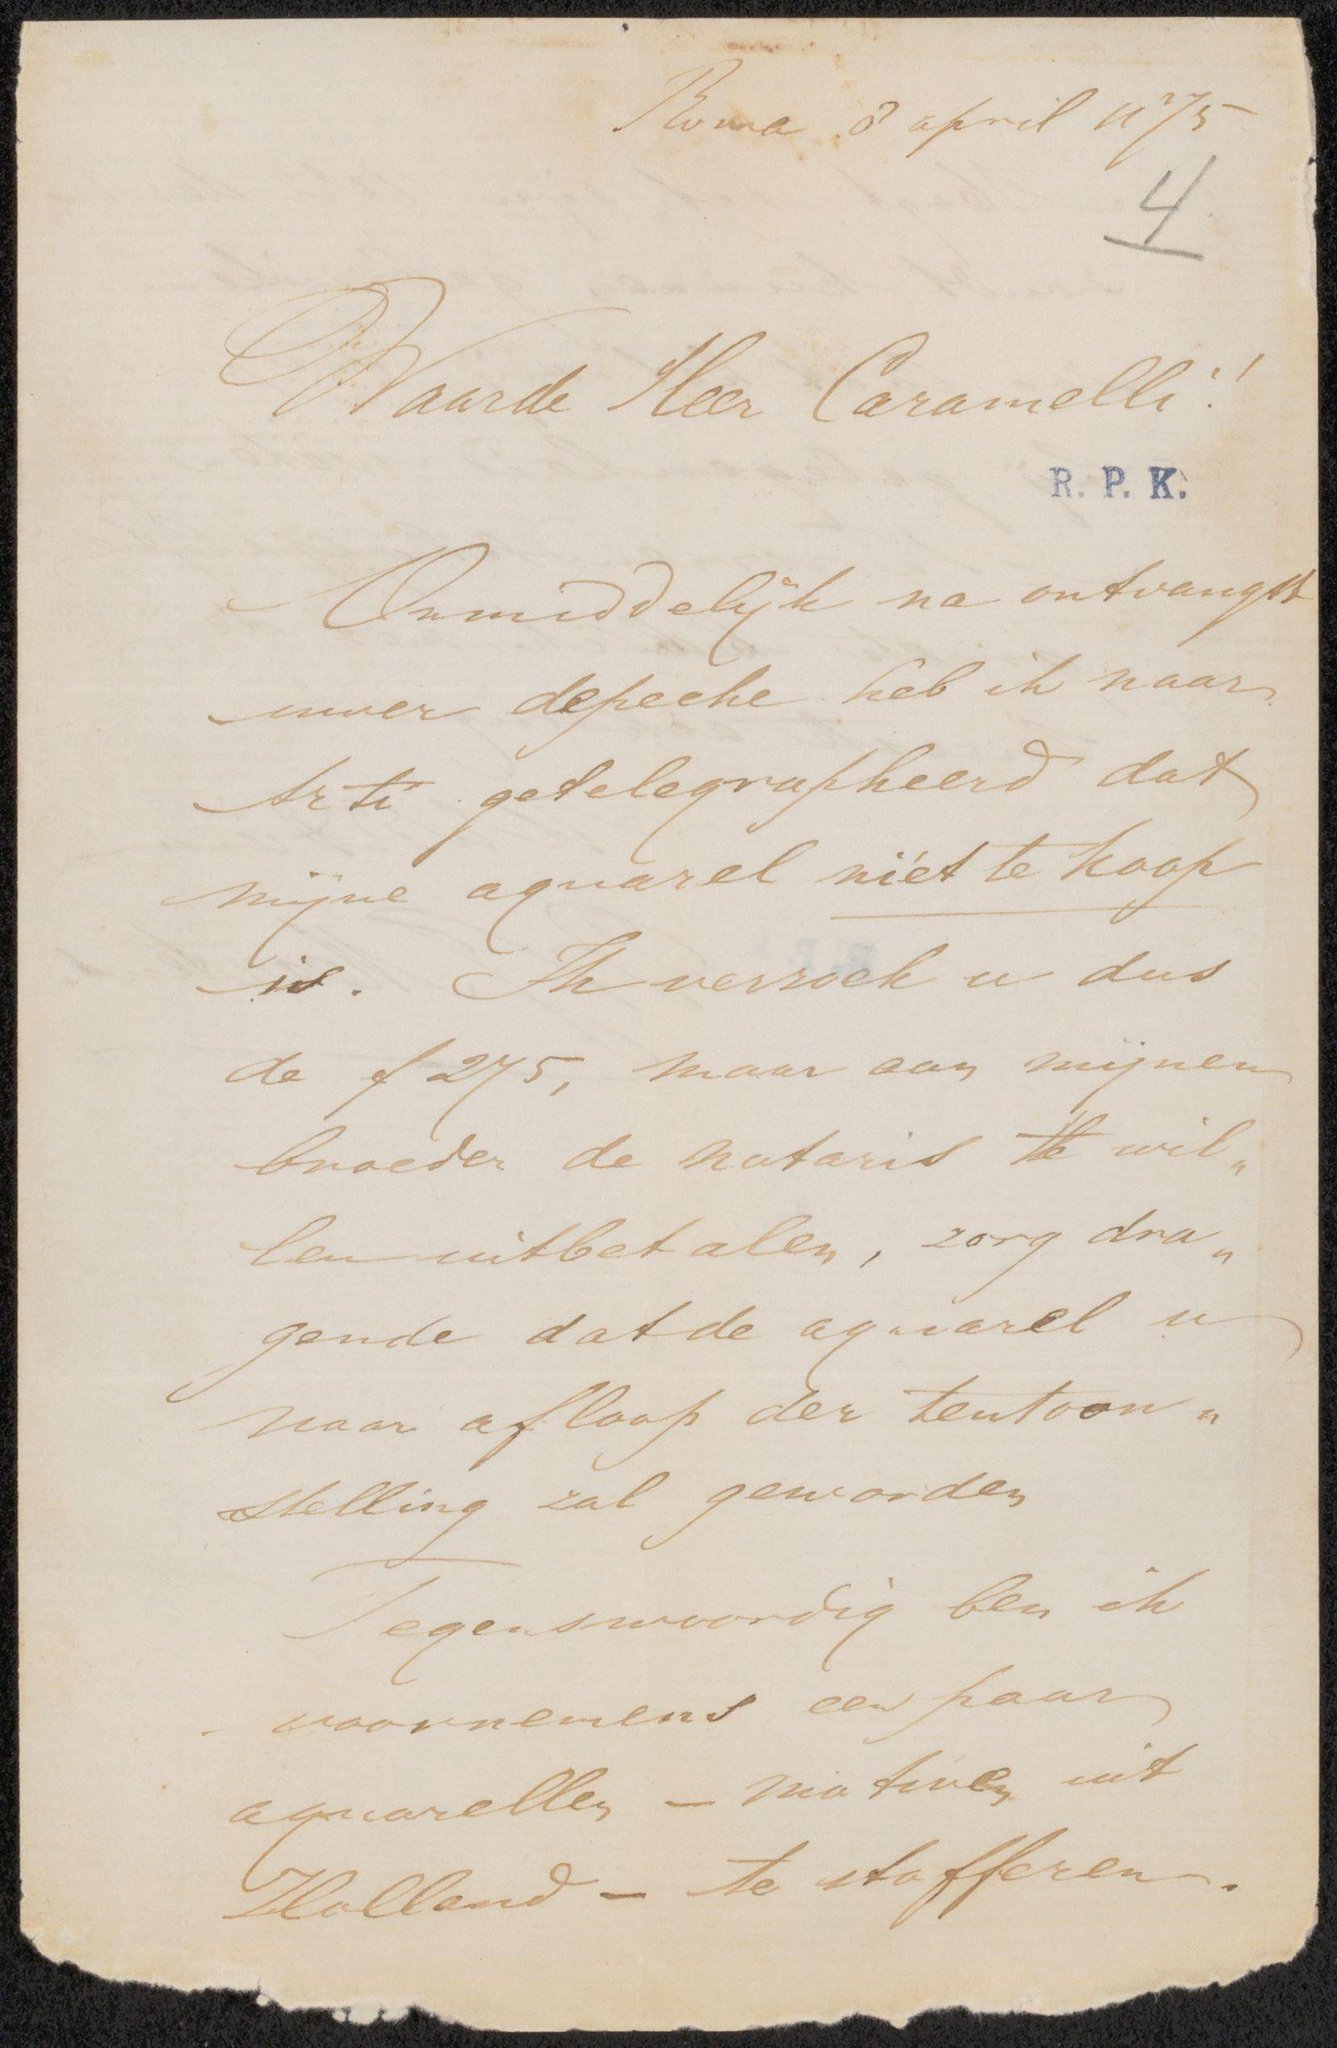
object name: letter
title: Brief aan de heer Caramelli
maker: willem johann martens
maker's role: draughtsman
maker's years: 1839-1895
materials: ink, paper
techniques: pen, writing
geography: rome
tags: art trade, art shop, drawing, exhibition ~ art, money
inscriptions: collector's mark: Lugt 2233